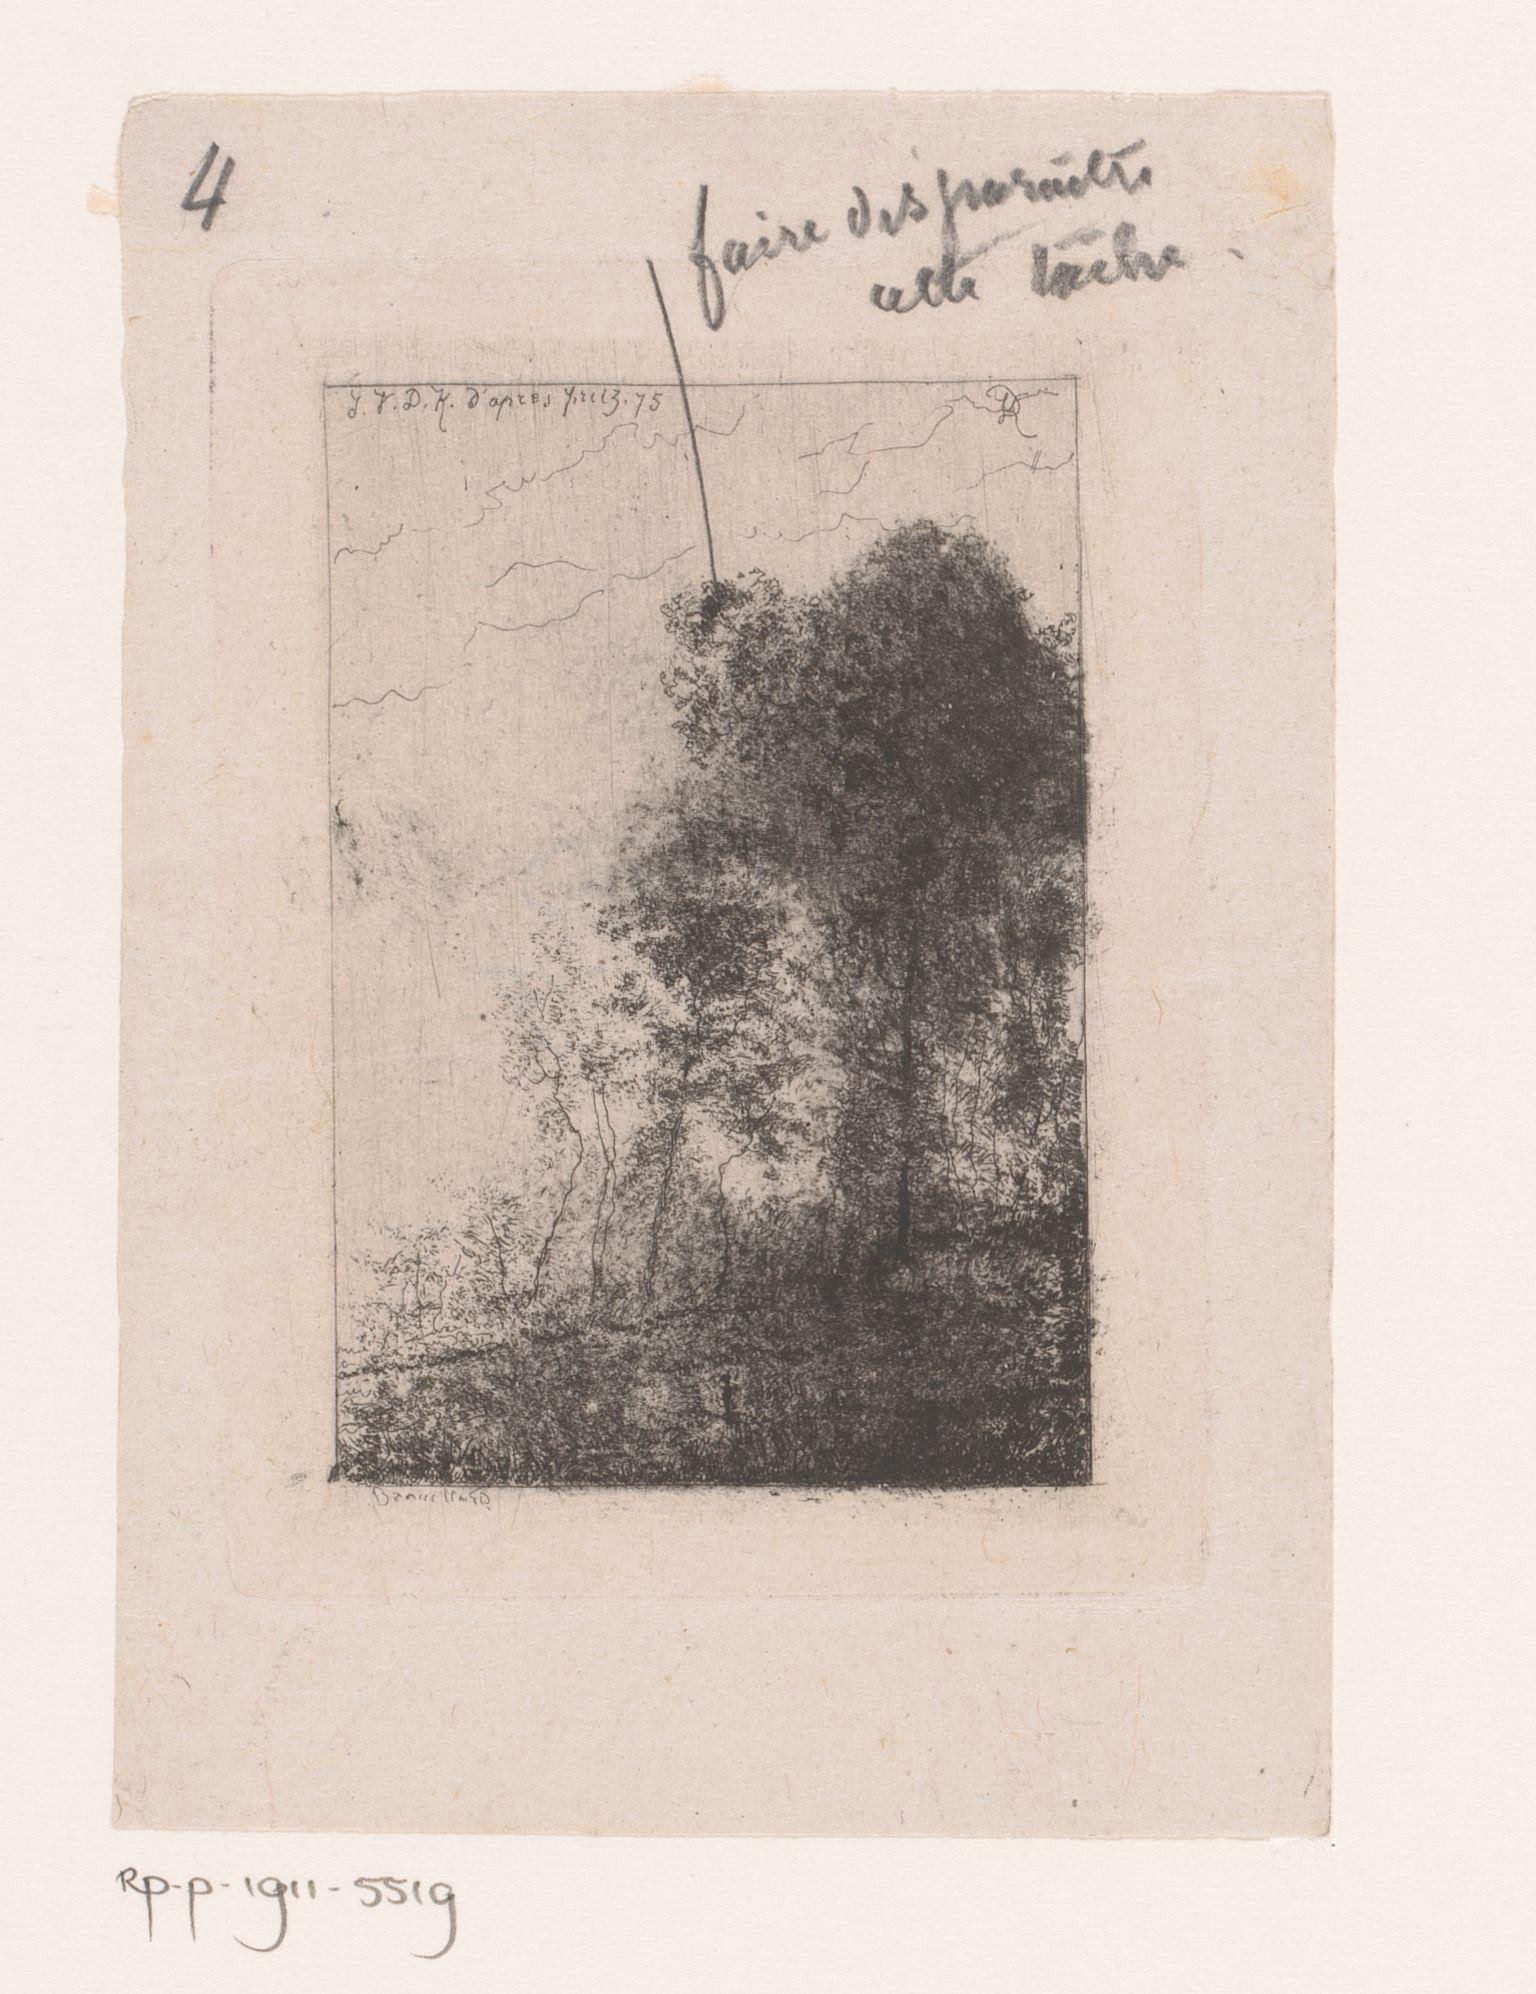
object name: print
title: Boslandschap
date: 1875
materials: paper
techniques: etching, intaglio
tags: forest, wood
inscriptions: annotation: ‘faire des [...]’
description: De etsen naar de schilderijen van Frédéric Van de Kerkhove werden na zijn dood door zijn vader en zuster gemaakt en uitgegeven in twee reeksen. De eerste werd in 1877 uitgegeven door het Journal des Beaux-Arts et de la Littérature: Cahier de 25 Eaux-fortes d'après Frédéric van de Kerkhove, gravées par son père et sa sœur. De tweede reeks van 126 etsen werd, ook in 1877, in Parijs uitgegeven bij A. Lévy onder de titel Cent eaux-fortes gravées par J. Van de Kerkhove d'après les tableaux de Frédéric Van de Kerkhove, mort en 1873 à l'âge de 10 ans et 11 mois.